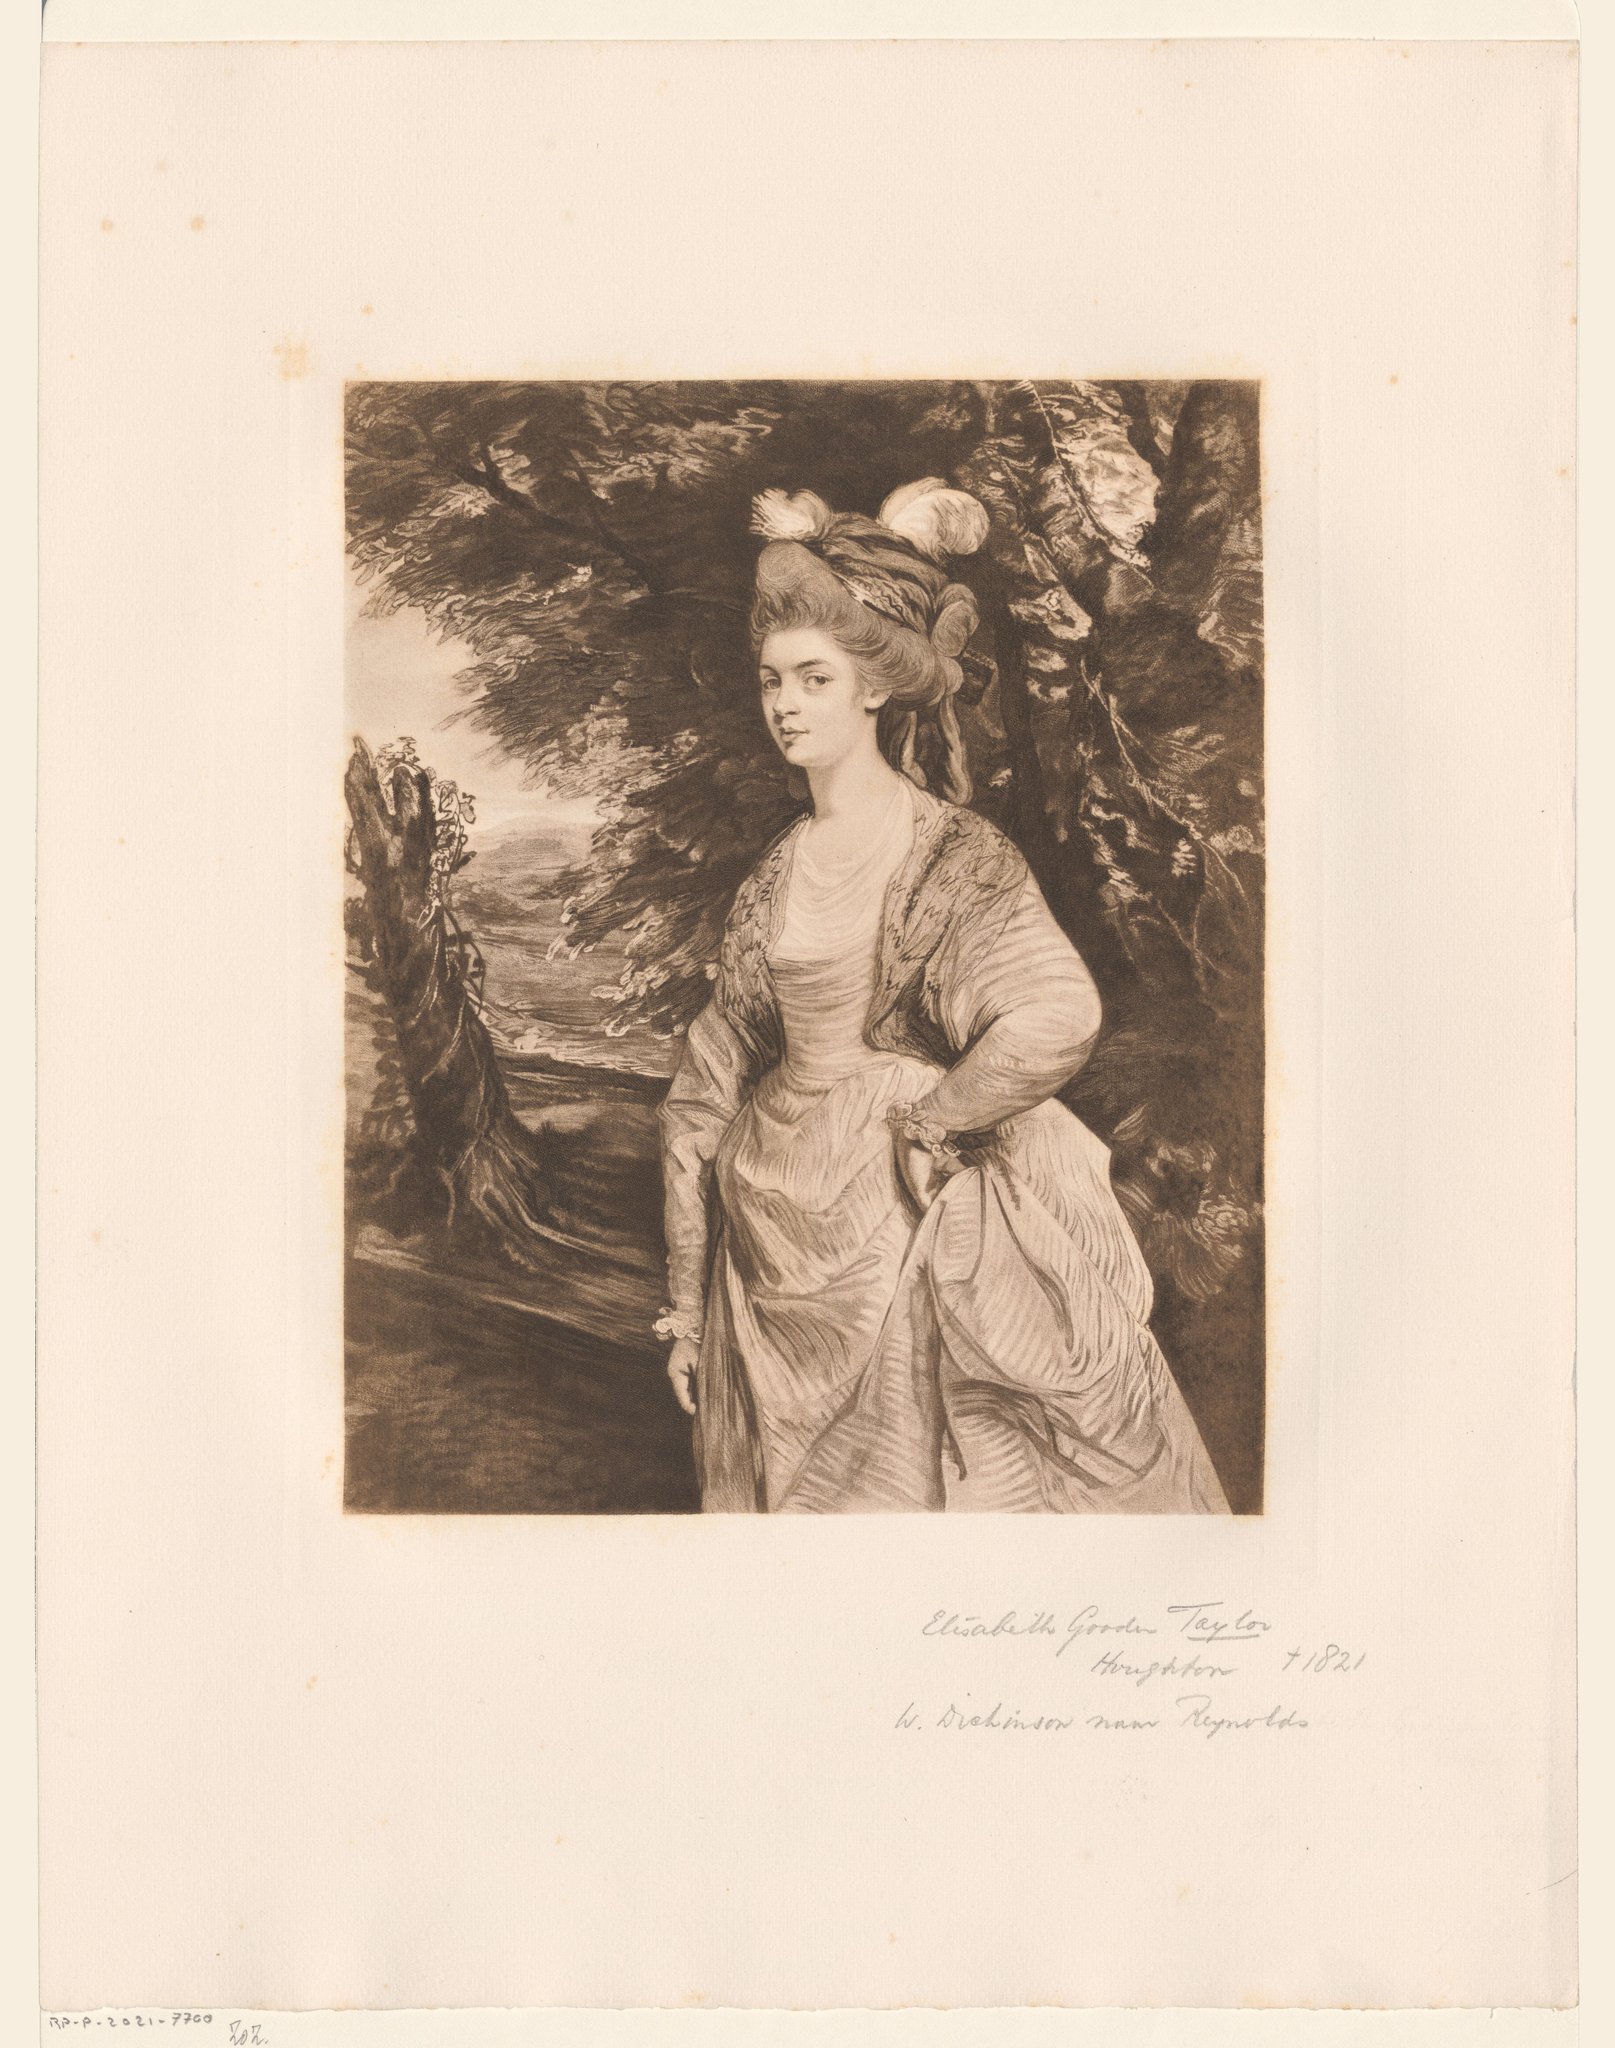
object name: photomechanical print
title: Portret van Elizabeth Taylor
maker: Anonymous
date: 1870-1915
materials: paper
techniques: photoaquatint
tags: historical persons - bb - woman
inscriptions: collector's mark: Lugt 2228